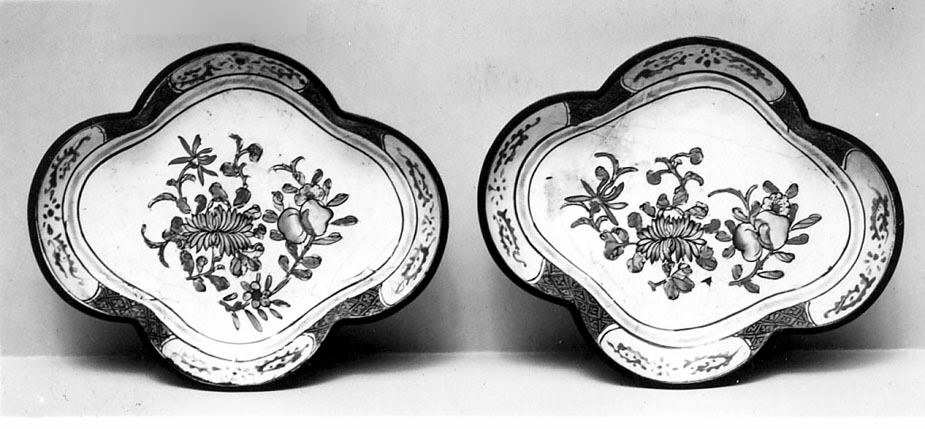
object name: tray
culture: chinese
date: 1801-1900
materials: enamel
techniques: painting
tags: flowers